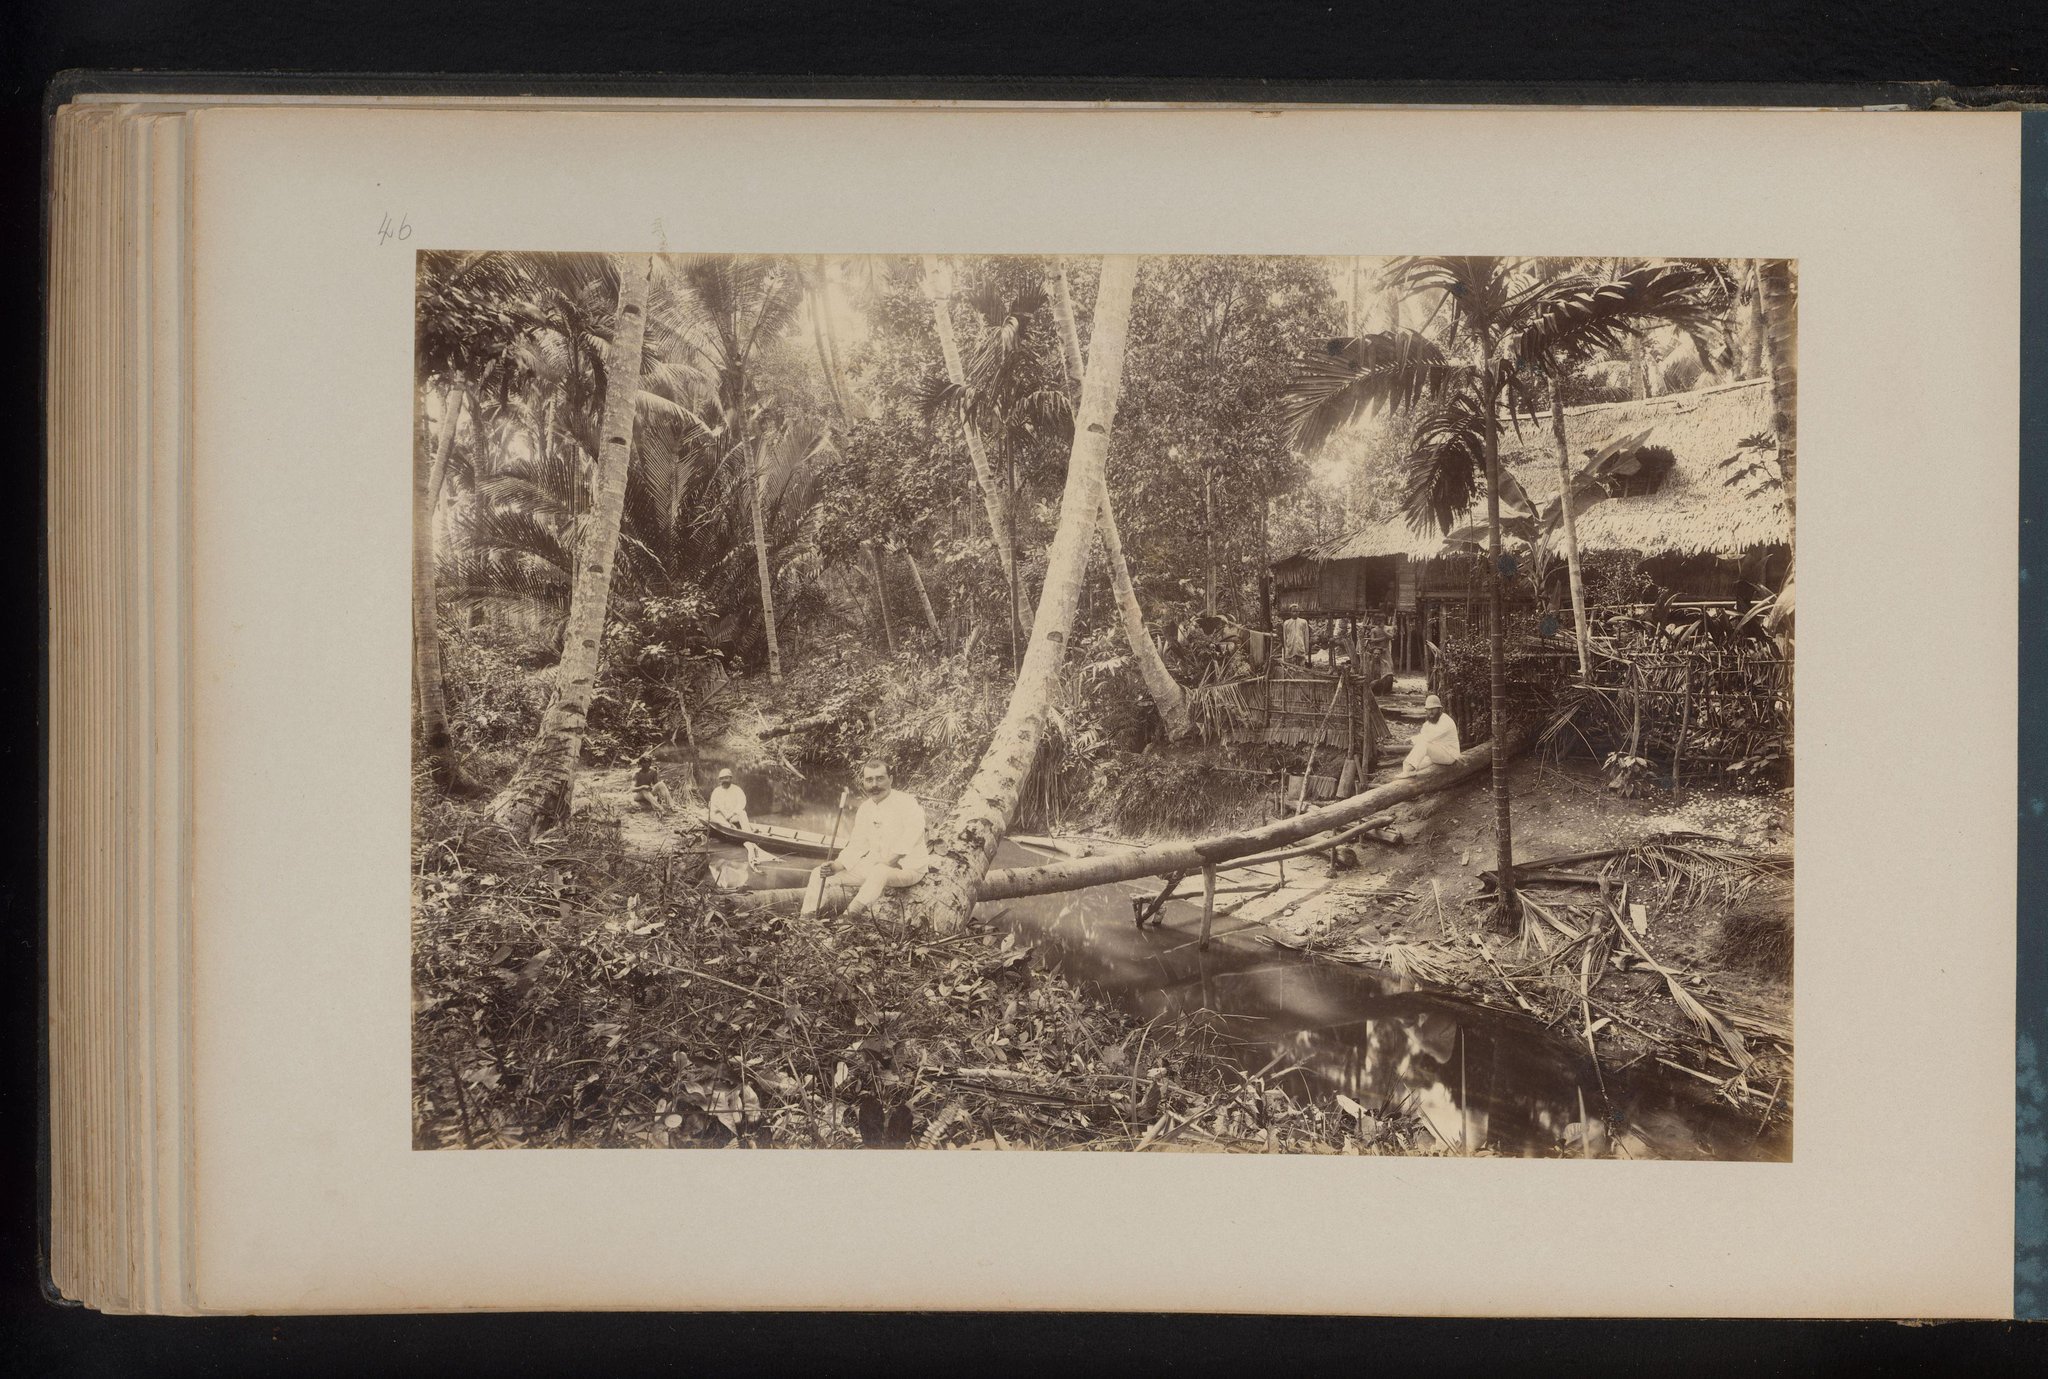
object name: photograph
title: Gezicht op een kampong in Bedagei, Sumatra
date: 1890-1900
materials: cardboard, photographic support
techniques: albumen print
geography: sumatra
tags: brook, interior of the house, sumatra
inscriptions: number: ‘46’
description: In de lijst van afbeeldingen wordt deze foto beschreven met de woorden "Malayisches Kampong in Bedagei".